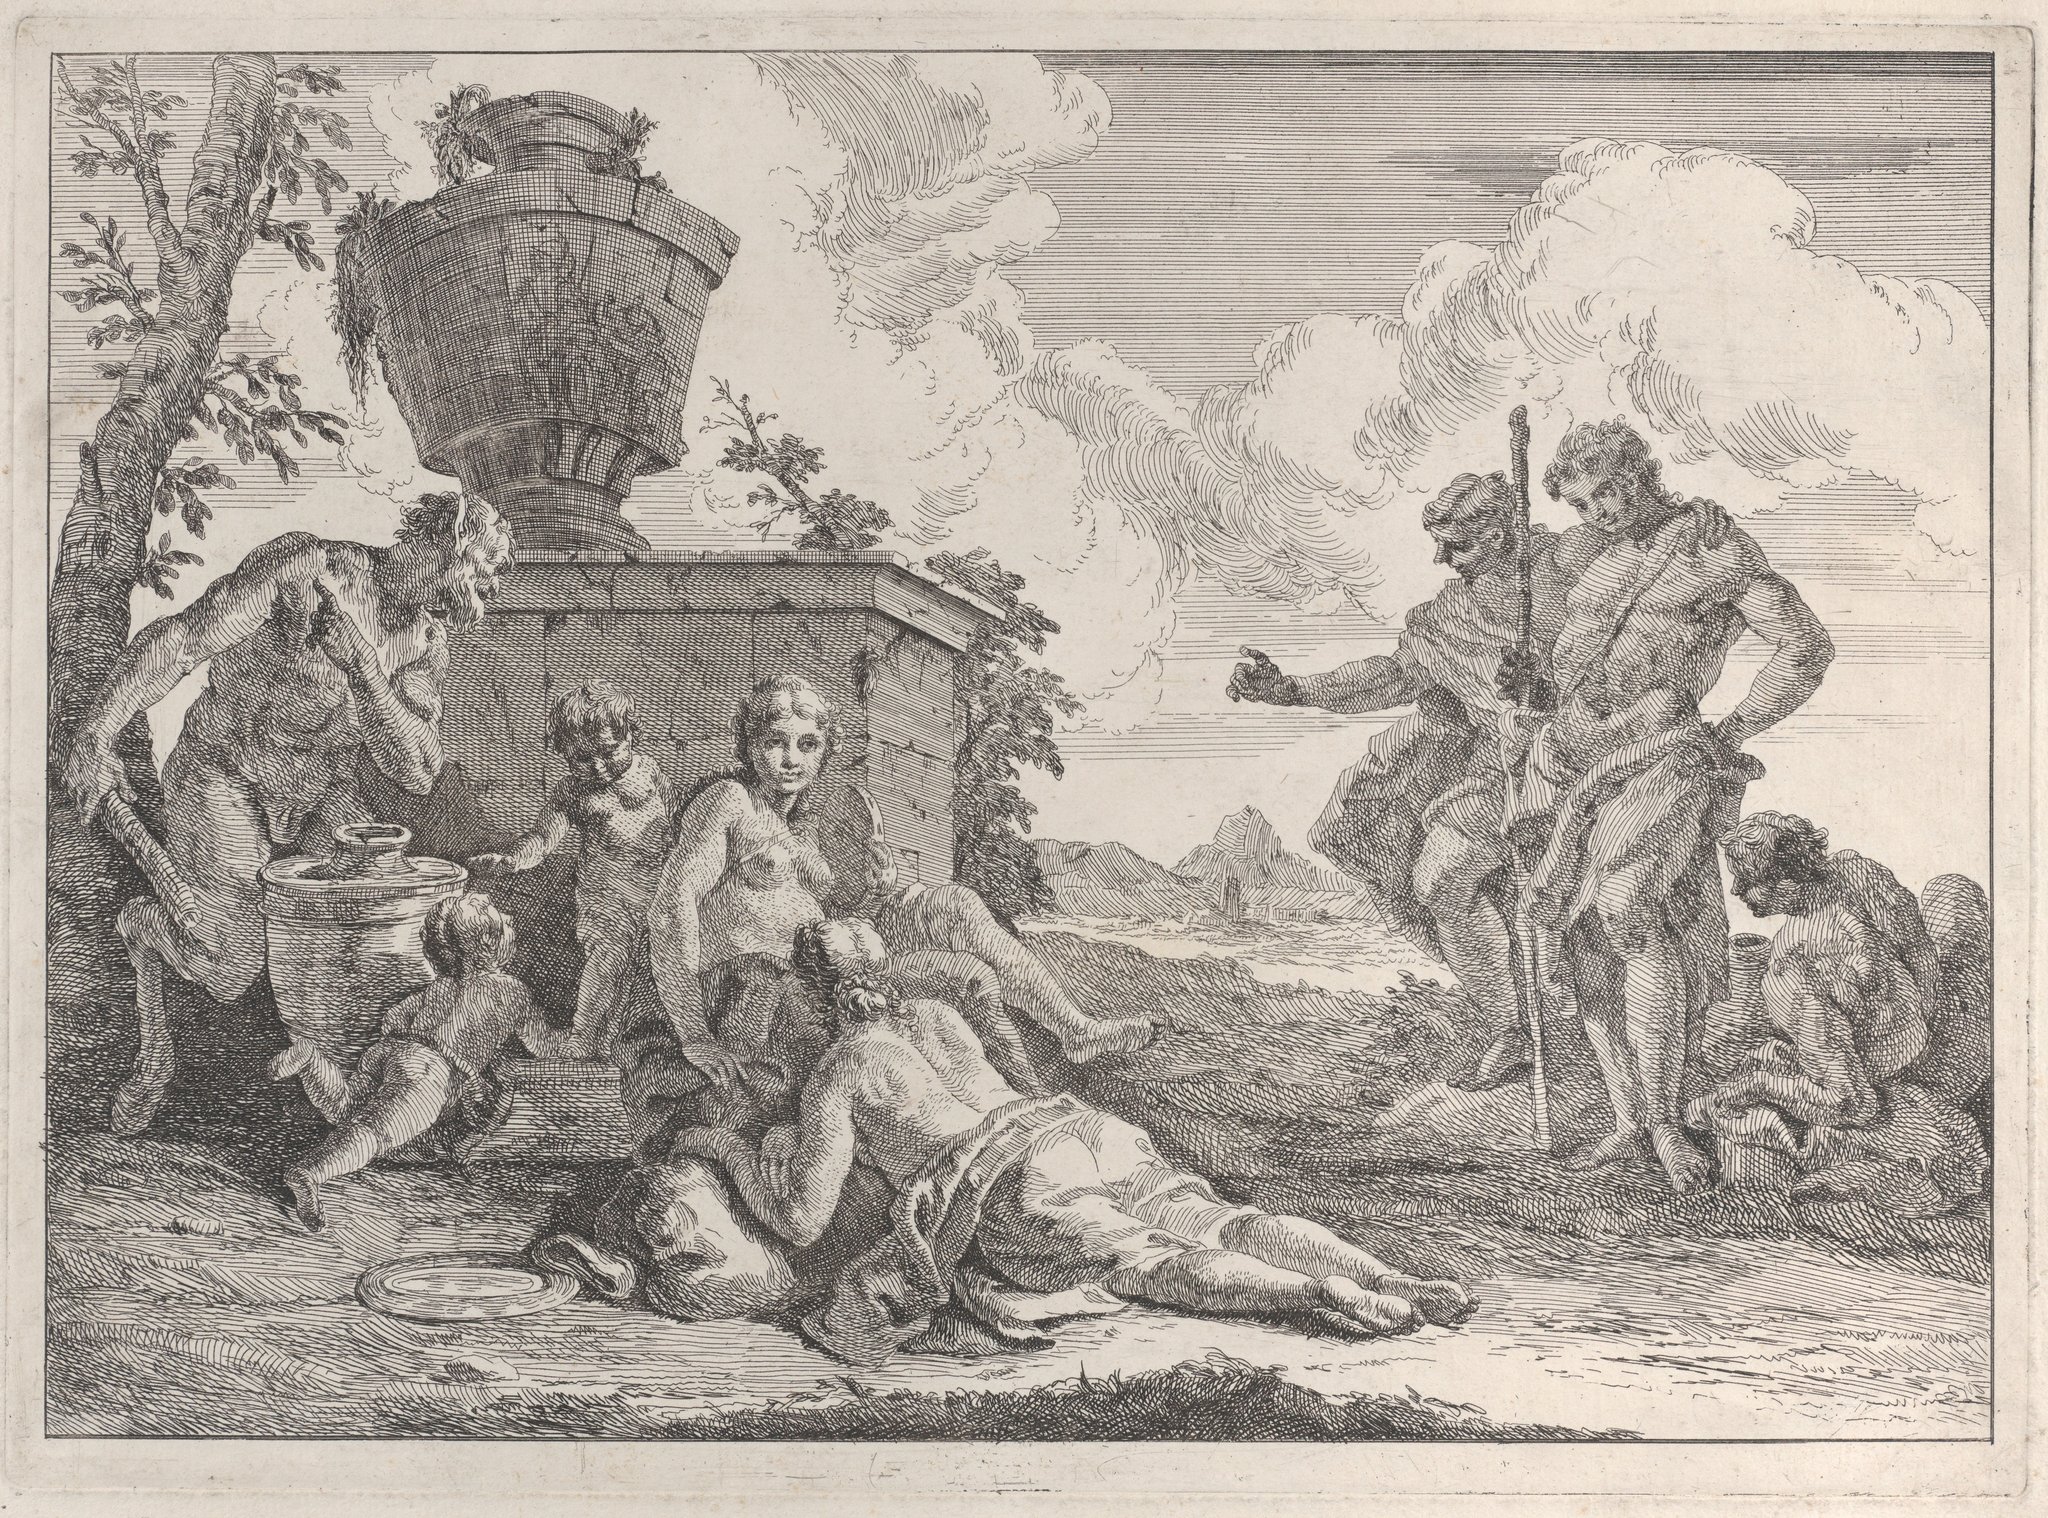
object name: print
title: Satyr with Club and Seven Figures, from "Bacchanals and Histories"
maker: francesco fontebasso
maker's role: artist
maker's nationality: italian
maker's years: 1707-1769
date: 1744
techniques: etching